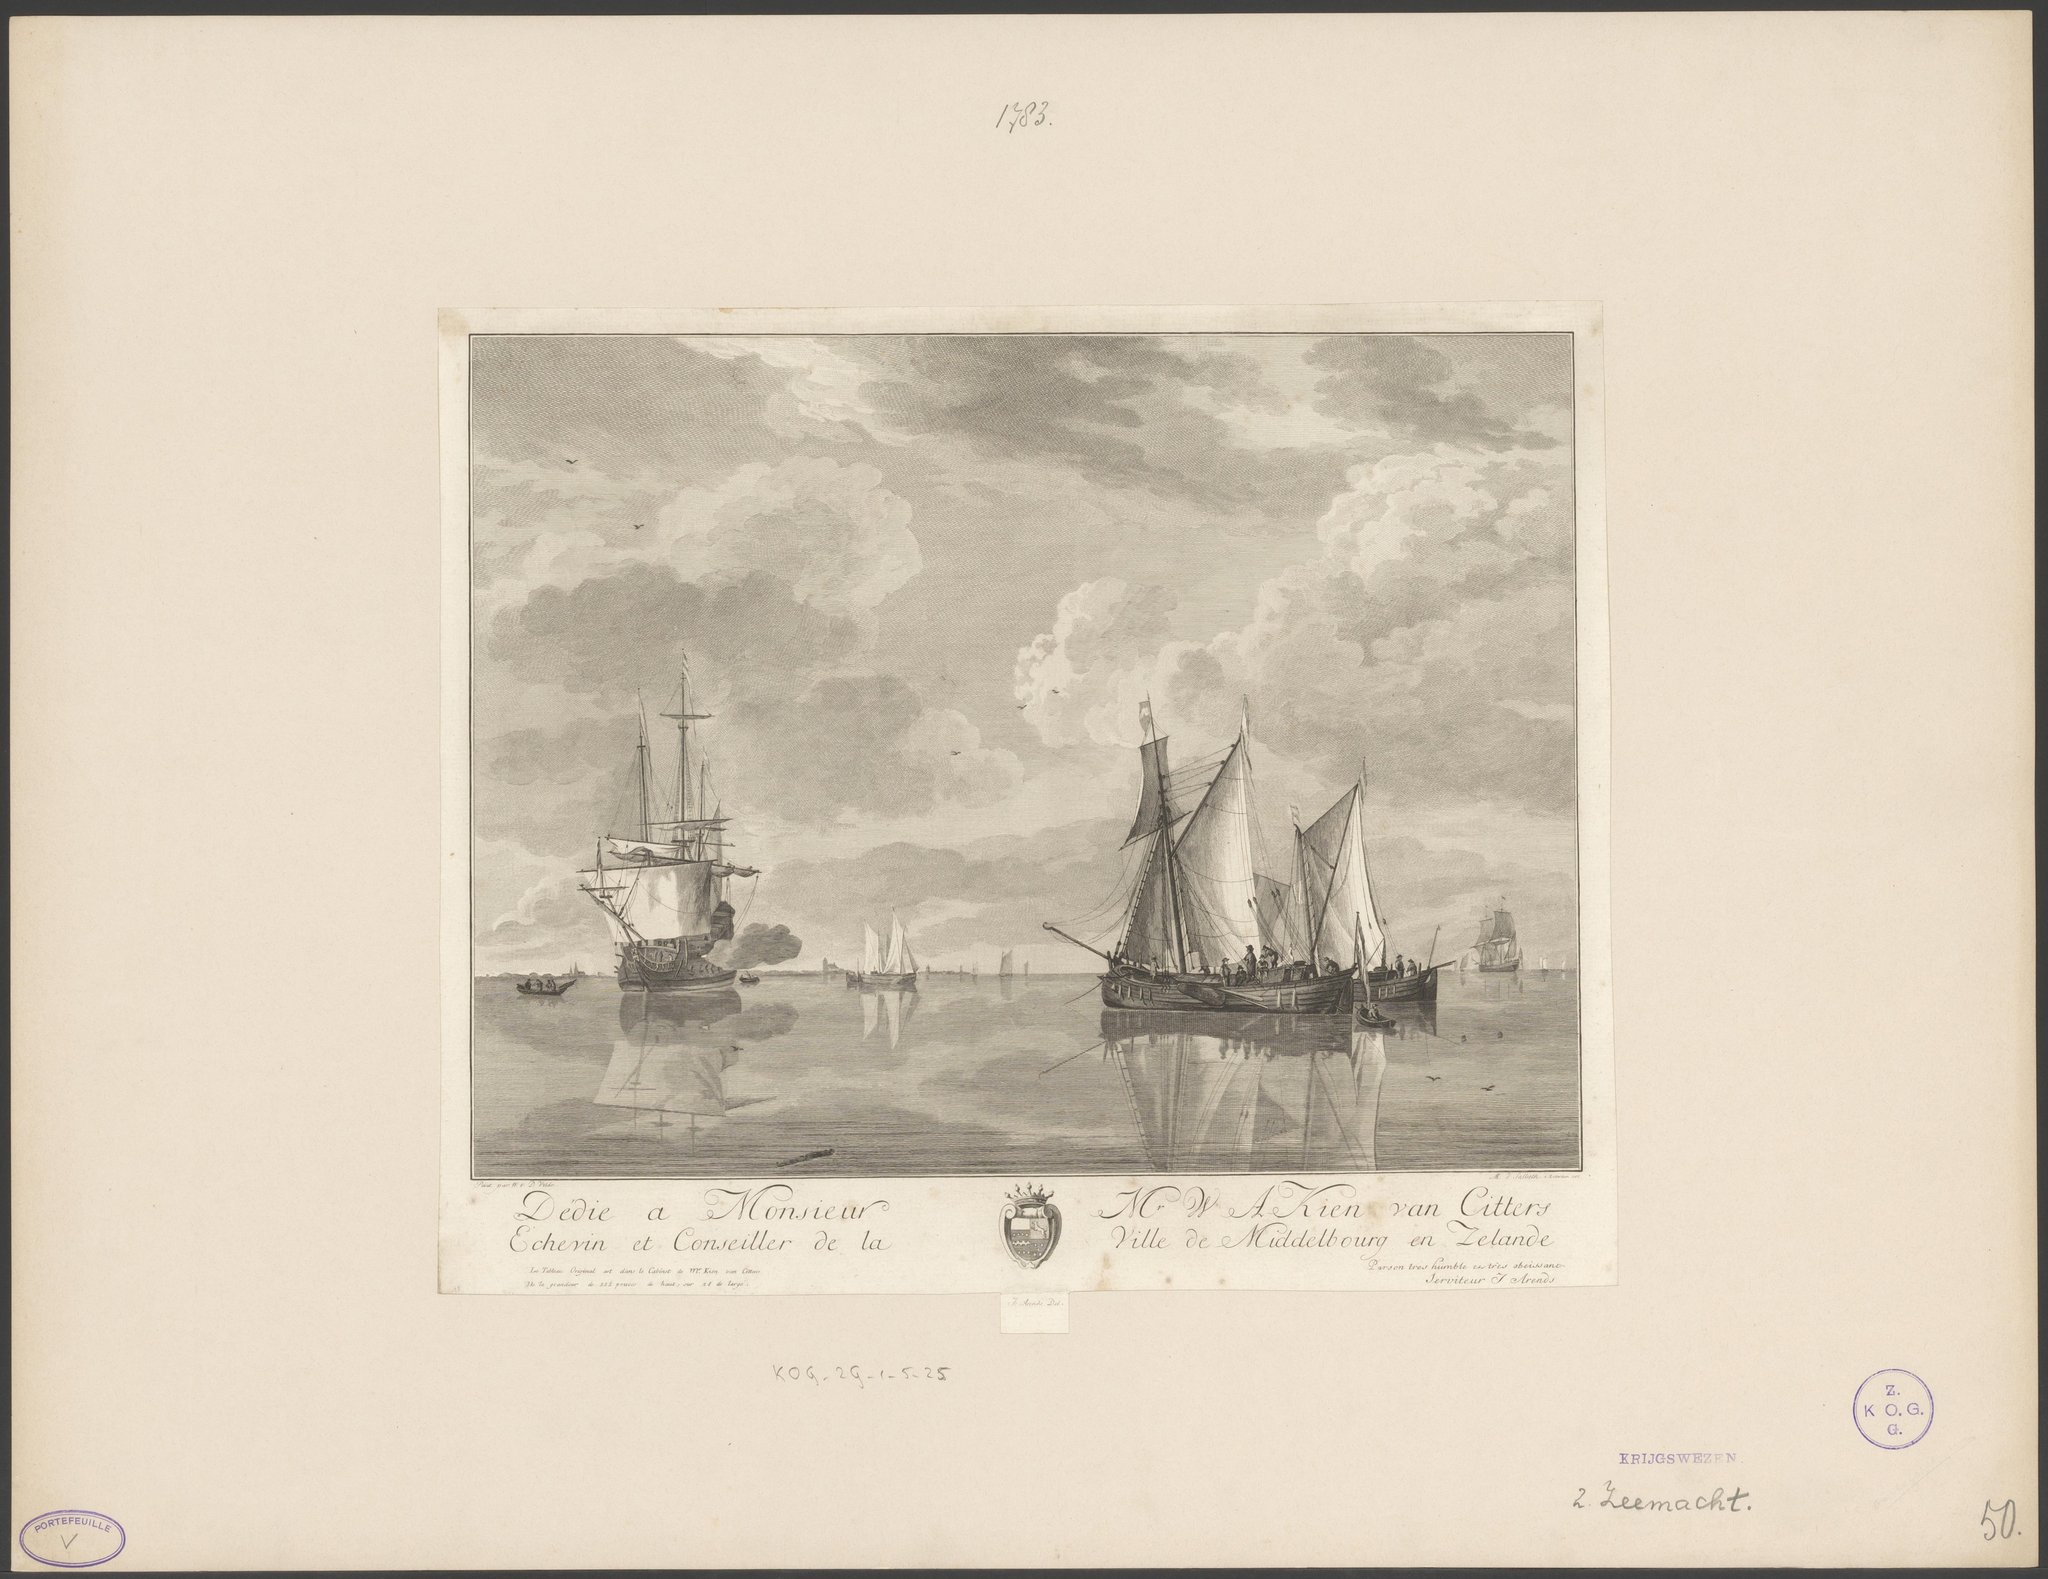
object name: print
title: Zeegezicht met zeilschepen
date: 1783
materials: paper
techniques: engraving, etching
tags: ships (in general) - cc - more than one ship, armorial bearing, heraldry, zeeland, middelburg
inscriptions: collector's mark: Lugt 1641, stamp, stamp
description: Zeegezicht met verschillende zeilschepen. Onderaan het familiewapen van de heer Kien van Citters. Onderwerpsrubrieken binnen de Atlas Zeden en Gewoonten: Krijgswezen, Zeemacht.